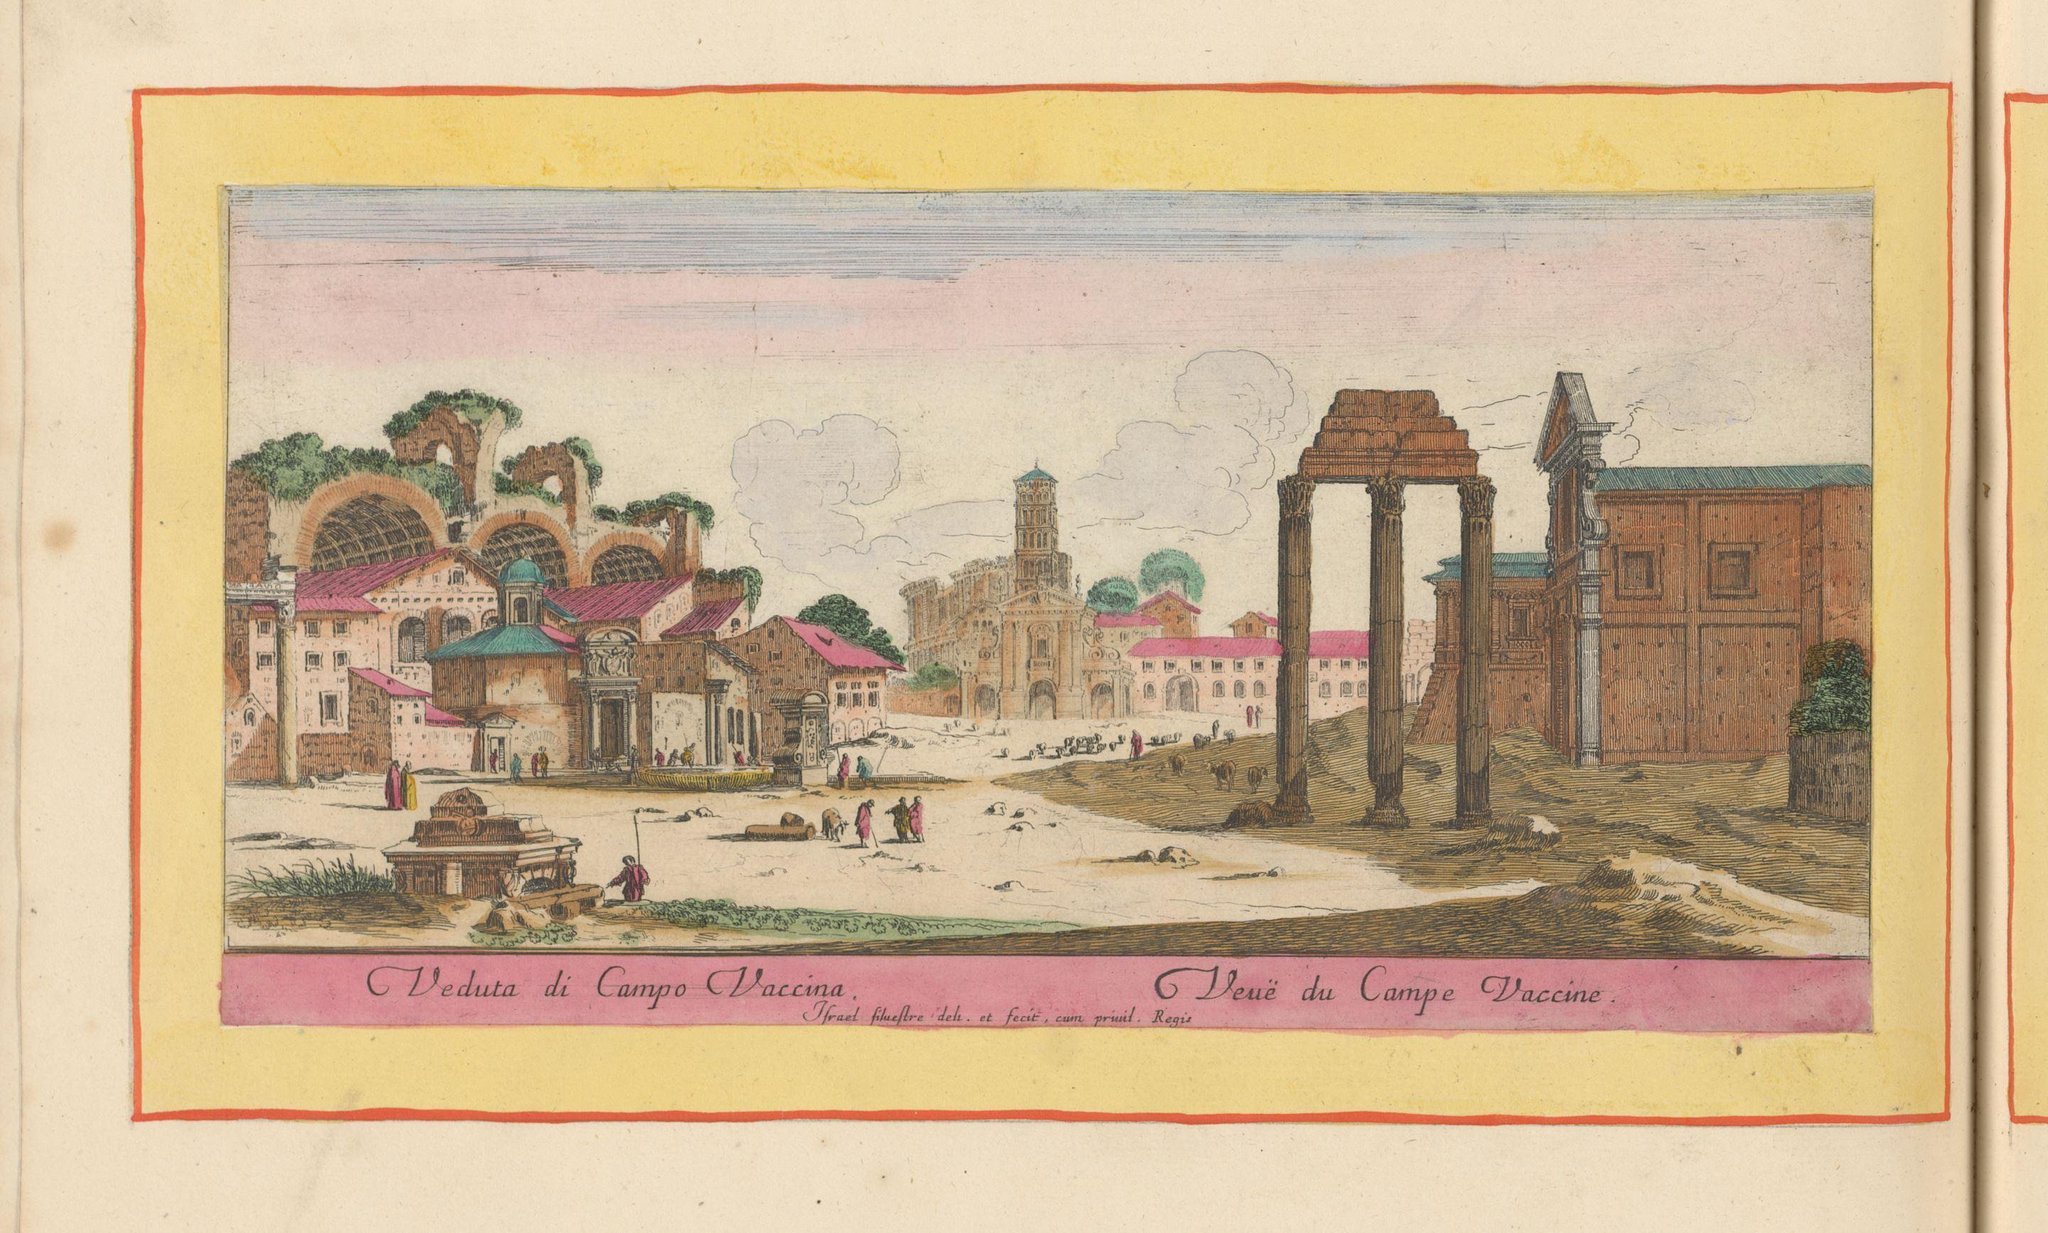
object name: print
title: Gezichten op Rome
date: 1631-1691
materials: paper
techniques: colour, etching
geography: the hague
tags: city-view, and landscape with man-made constructions, ruin of a building ~ architecture, landscape with ruins, temple, shrine ~ roman religion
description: Gezicht op het Forum Romanum te Rome, met op de achtergrond links de Basilica van Maxentius. Titel in het Italiaans en het Frans in de ondermarge. Prent maakt deel uit van een album.